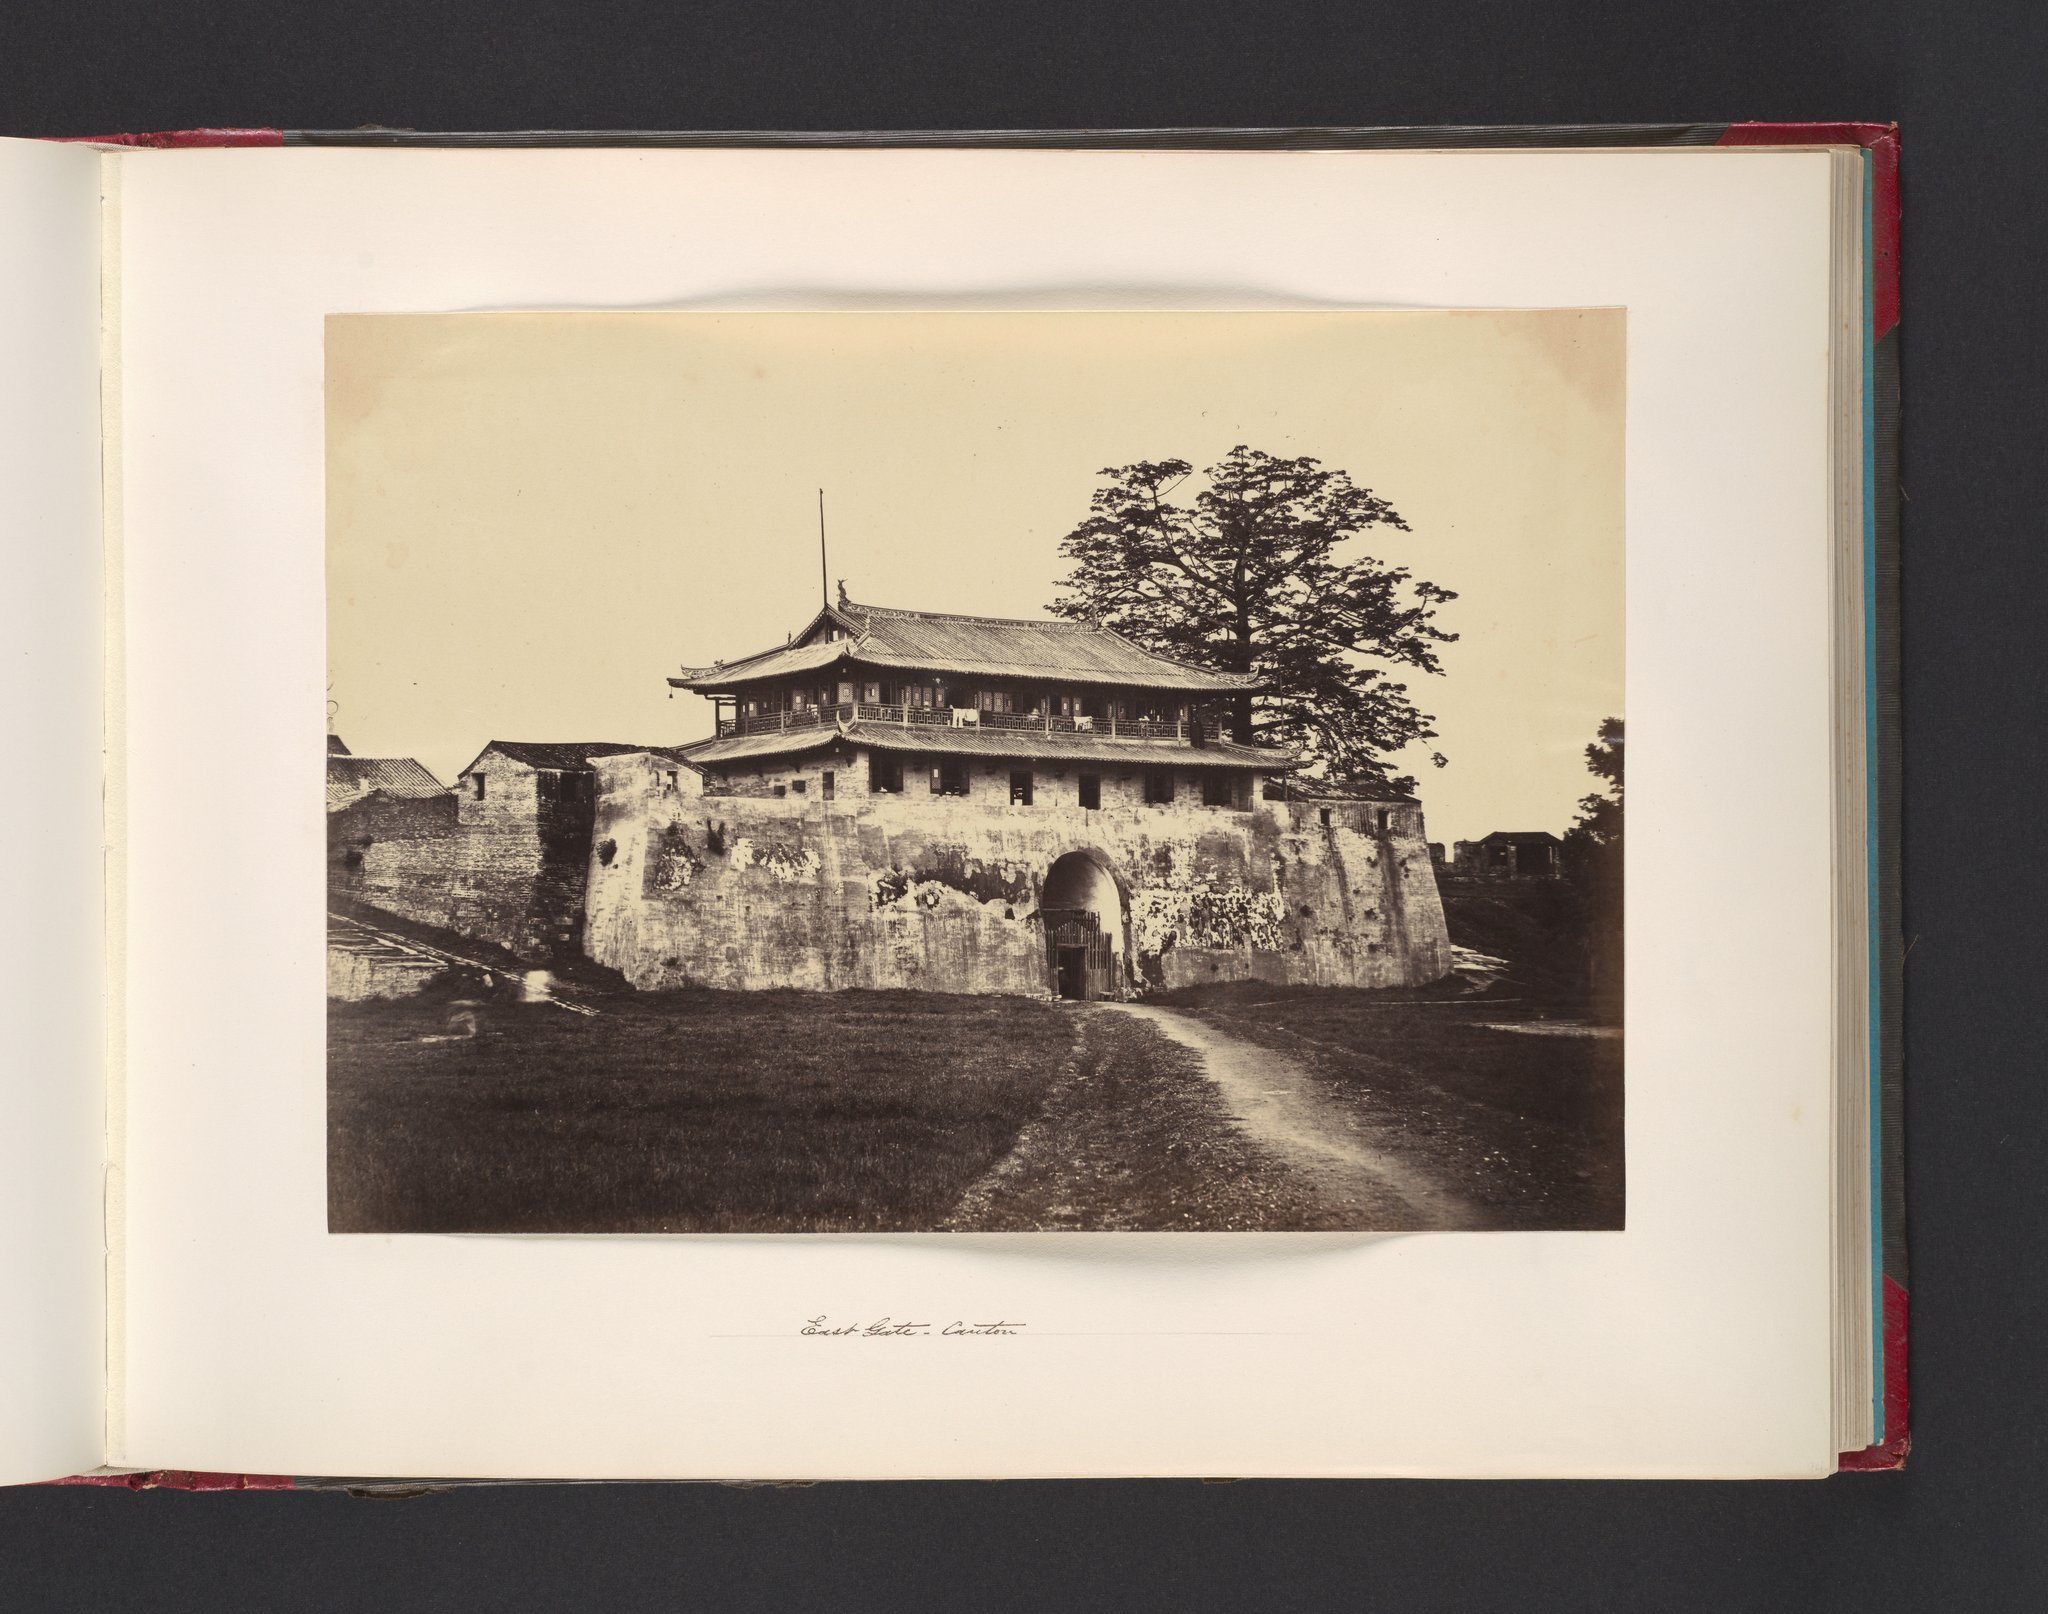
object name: photograph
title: East Gate, Canton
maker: john thomson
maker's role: artist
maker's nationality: british, scottish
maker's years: 1837-1921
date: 1865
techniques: albumen silver print, glass negative